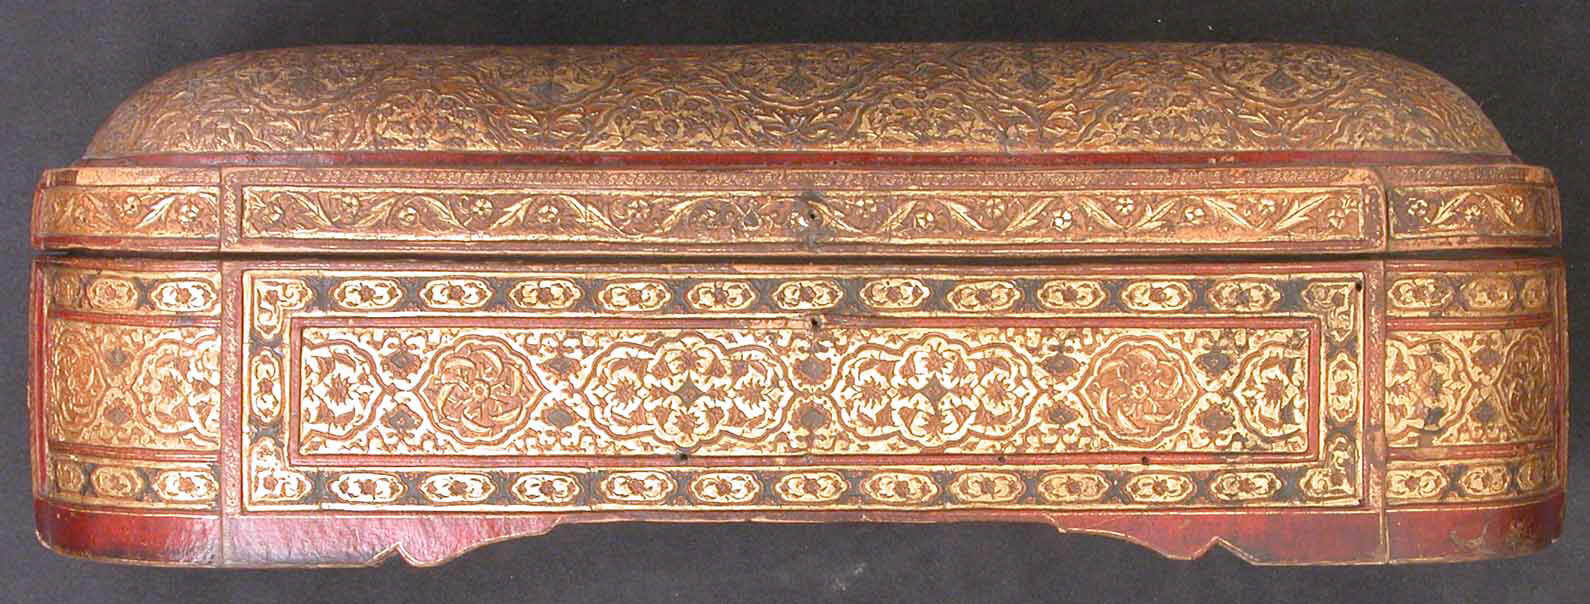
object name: pen box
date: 1600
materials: leather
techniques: gilding, painting, stamping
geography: turkey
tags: flowers